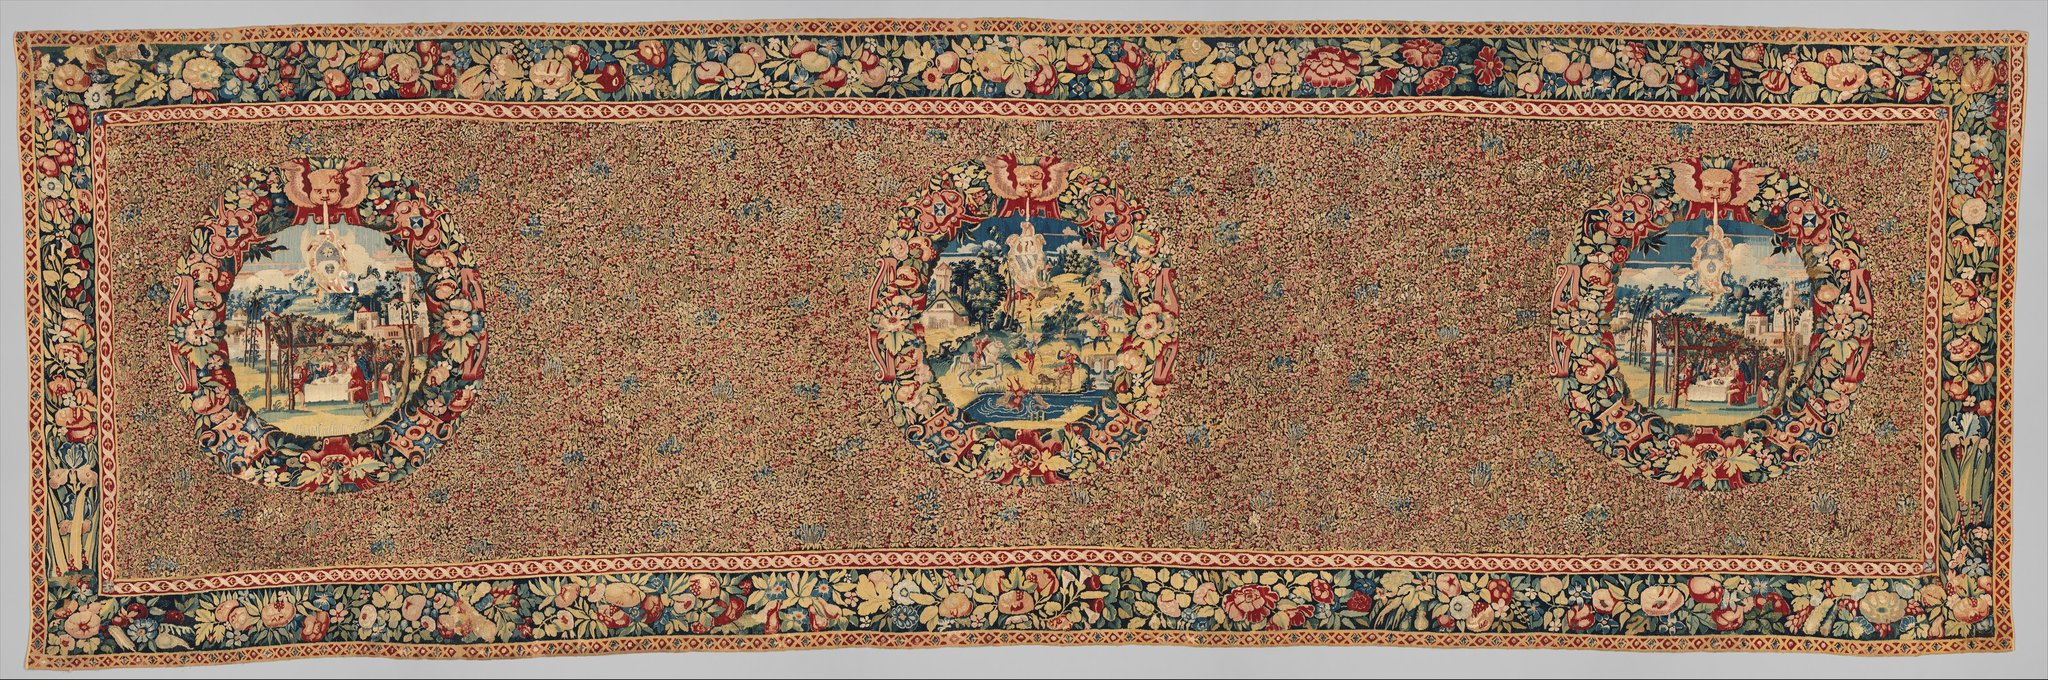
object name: tapestry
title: Cartouches with landscapes and armorials against a mille-fleurs ground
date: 1550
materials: silk, wool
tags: flowers,coat of arms